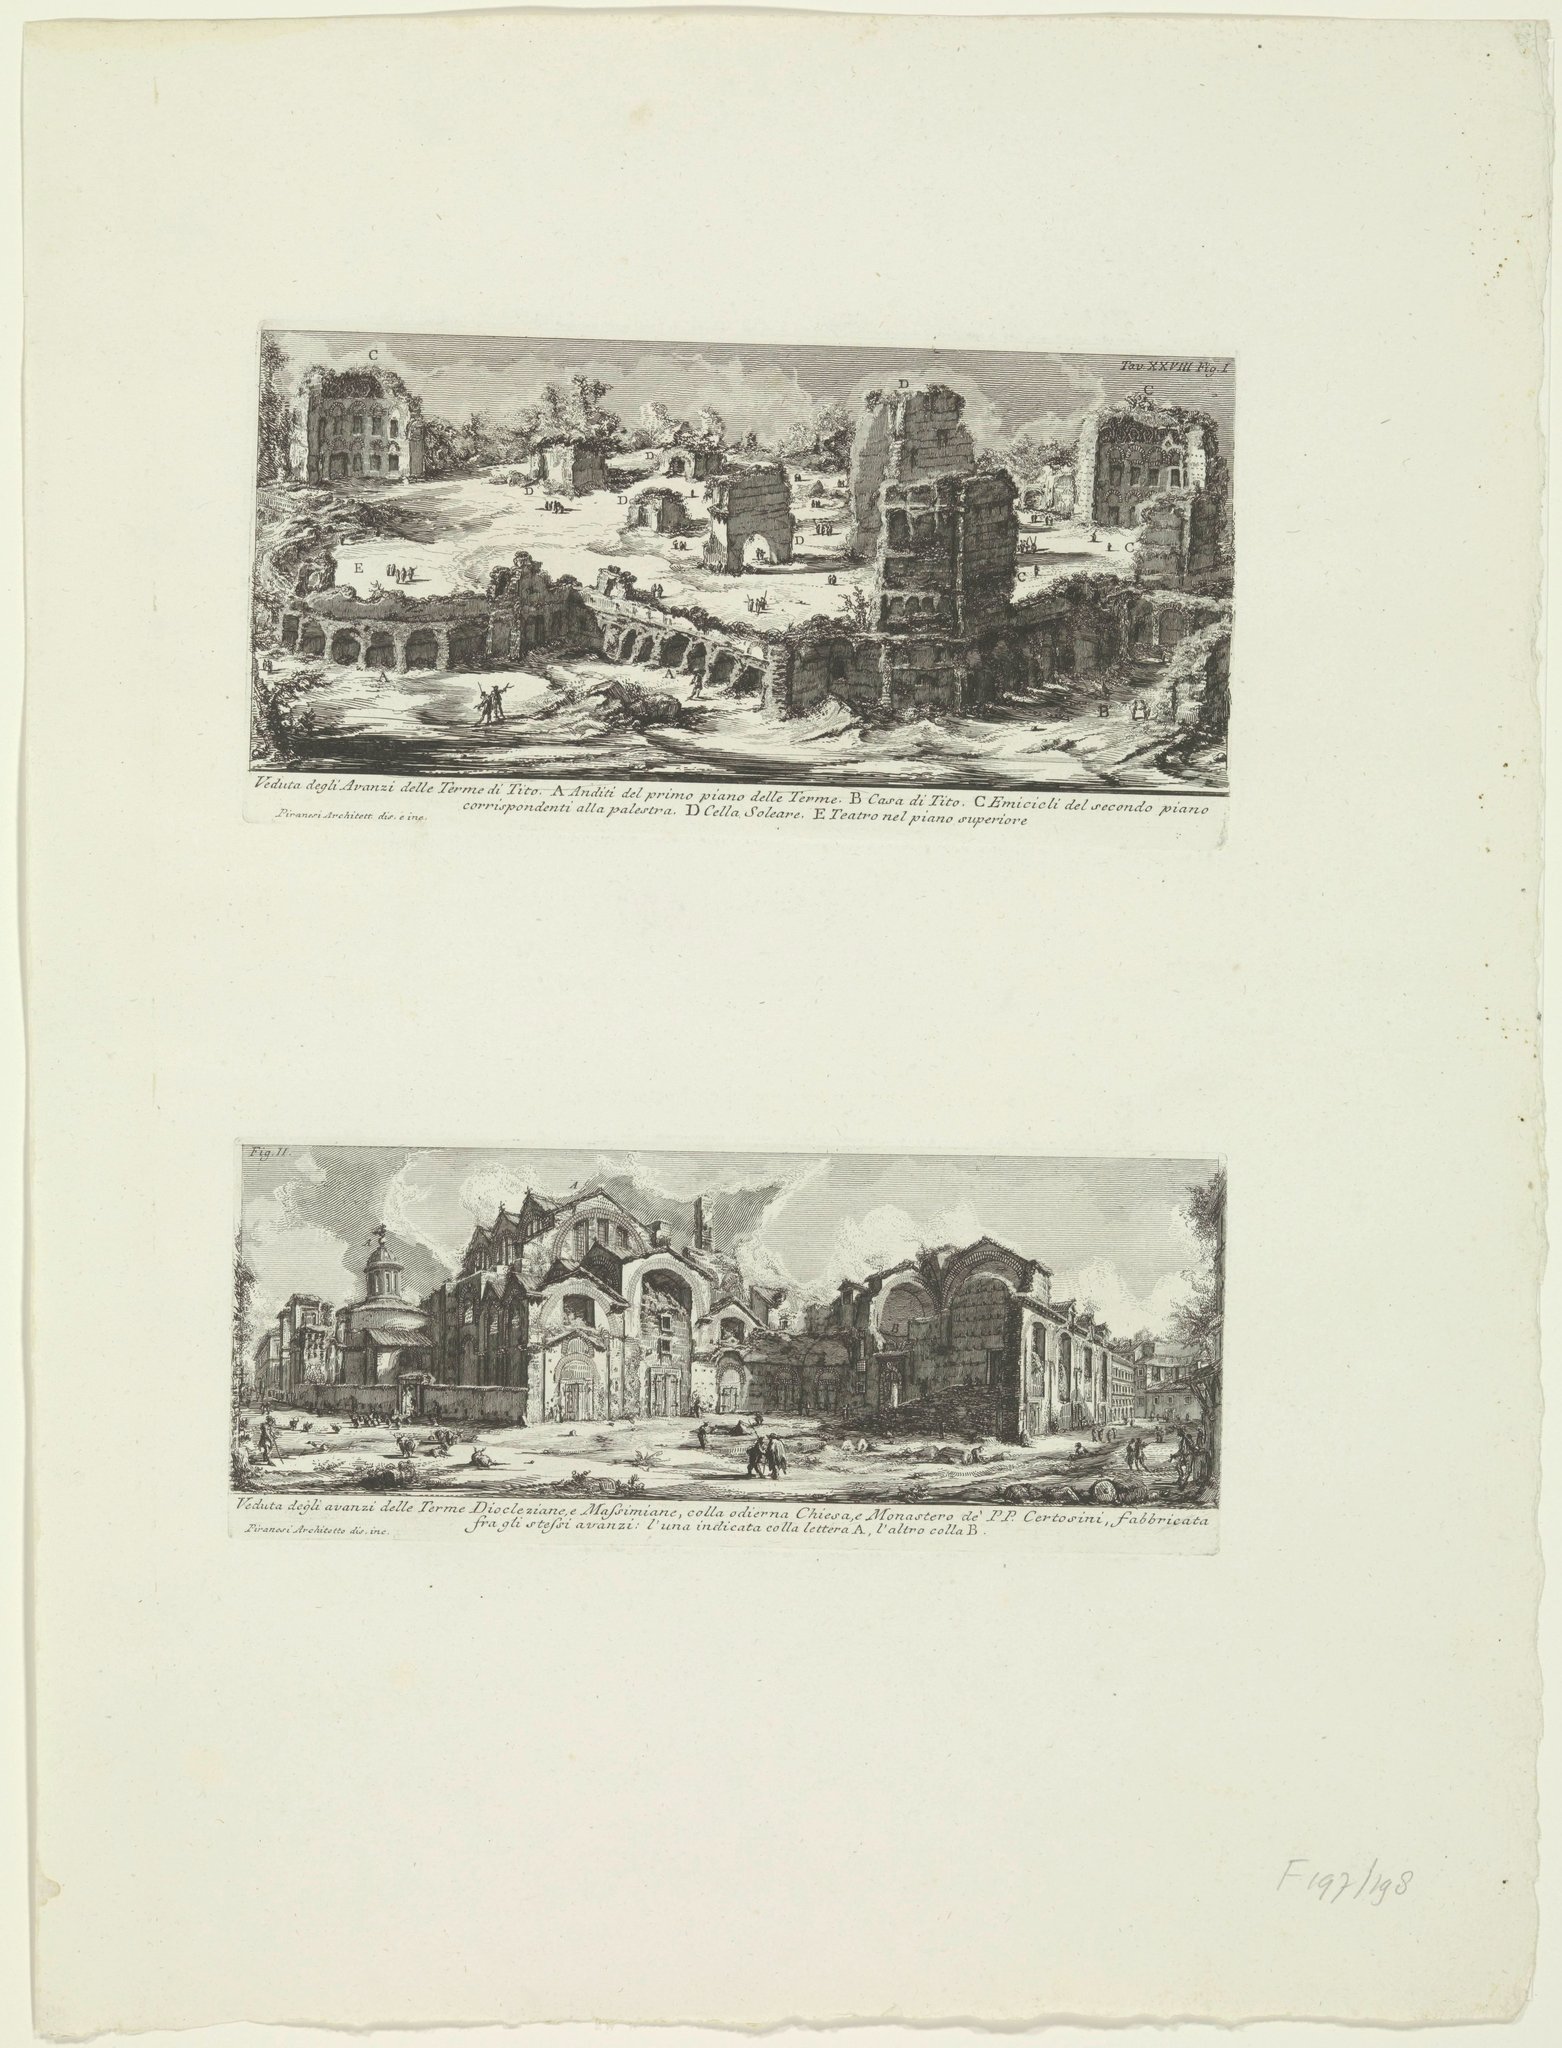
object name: print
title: Veduta degli avanzi delle Terme Diocleziane, e Massimian (...) (onder)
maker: giovanni battista piranesi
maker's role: designer, draughtsman, print maker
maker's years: 1720-1778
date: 1756-1757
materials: paper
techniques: etching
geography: rome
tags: city-view, and landscape with man-made constructions, ruin of a building ~ architecture, church (exterior), public baths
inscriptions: collector's mark: Lugt 2228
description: Blad met twee voorstellingen van Romeinse Thermen. Boven: gezicht op resten van de Thermen van Trajanus (op prent geïdentificeerd als Thermen van Titus). Genummerd rechtsboven: Tav. XXVIII Fig. I. Titel en verklarende lijst met letters in ondermarge. Onder: gezicht op restanten van de Thermen van Diocletianus met links een kerk. Genummerd linksboven: Fig. II. Titel in ondermarge.